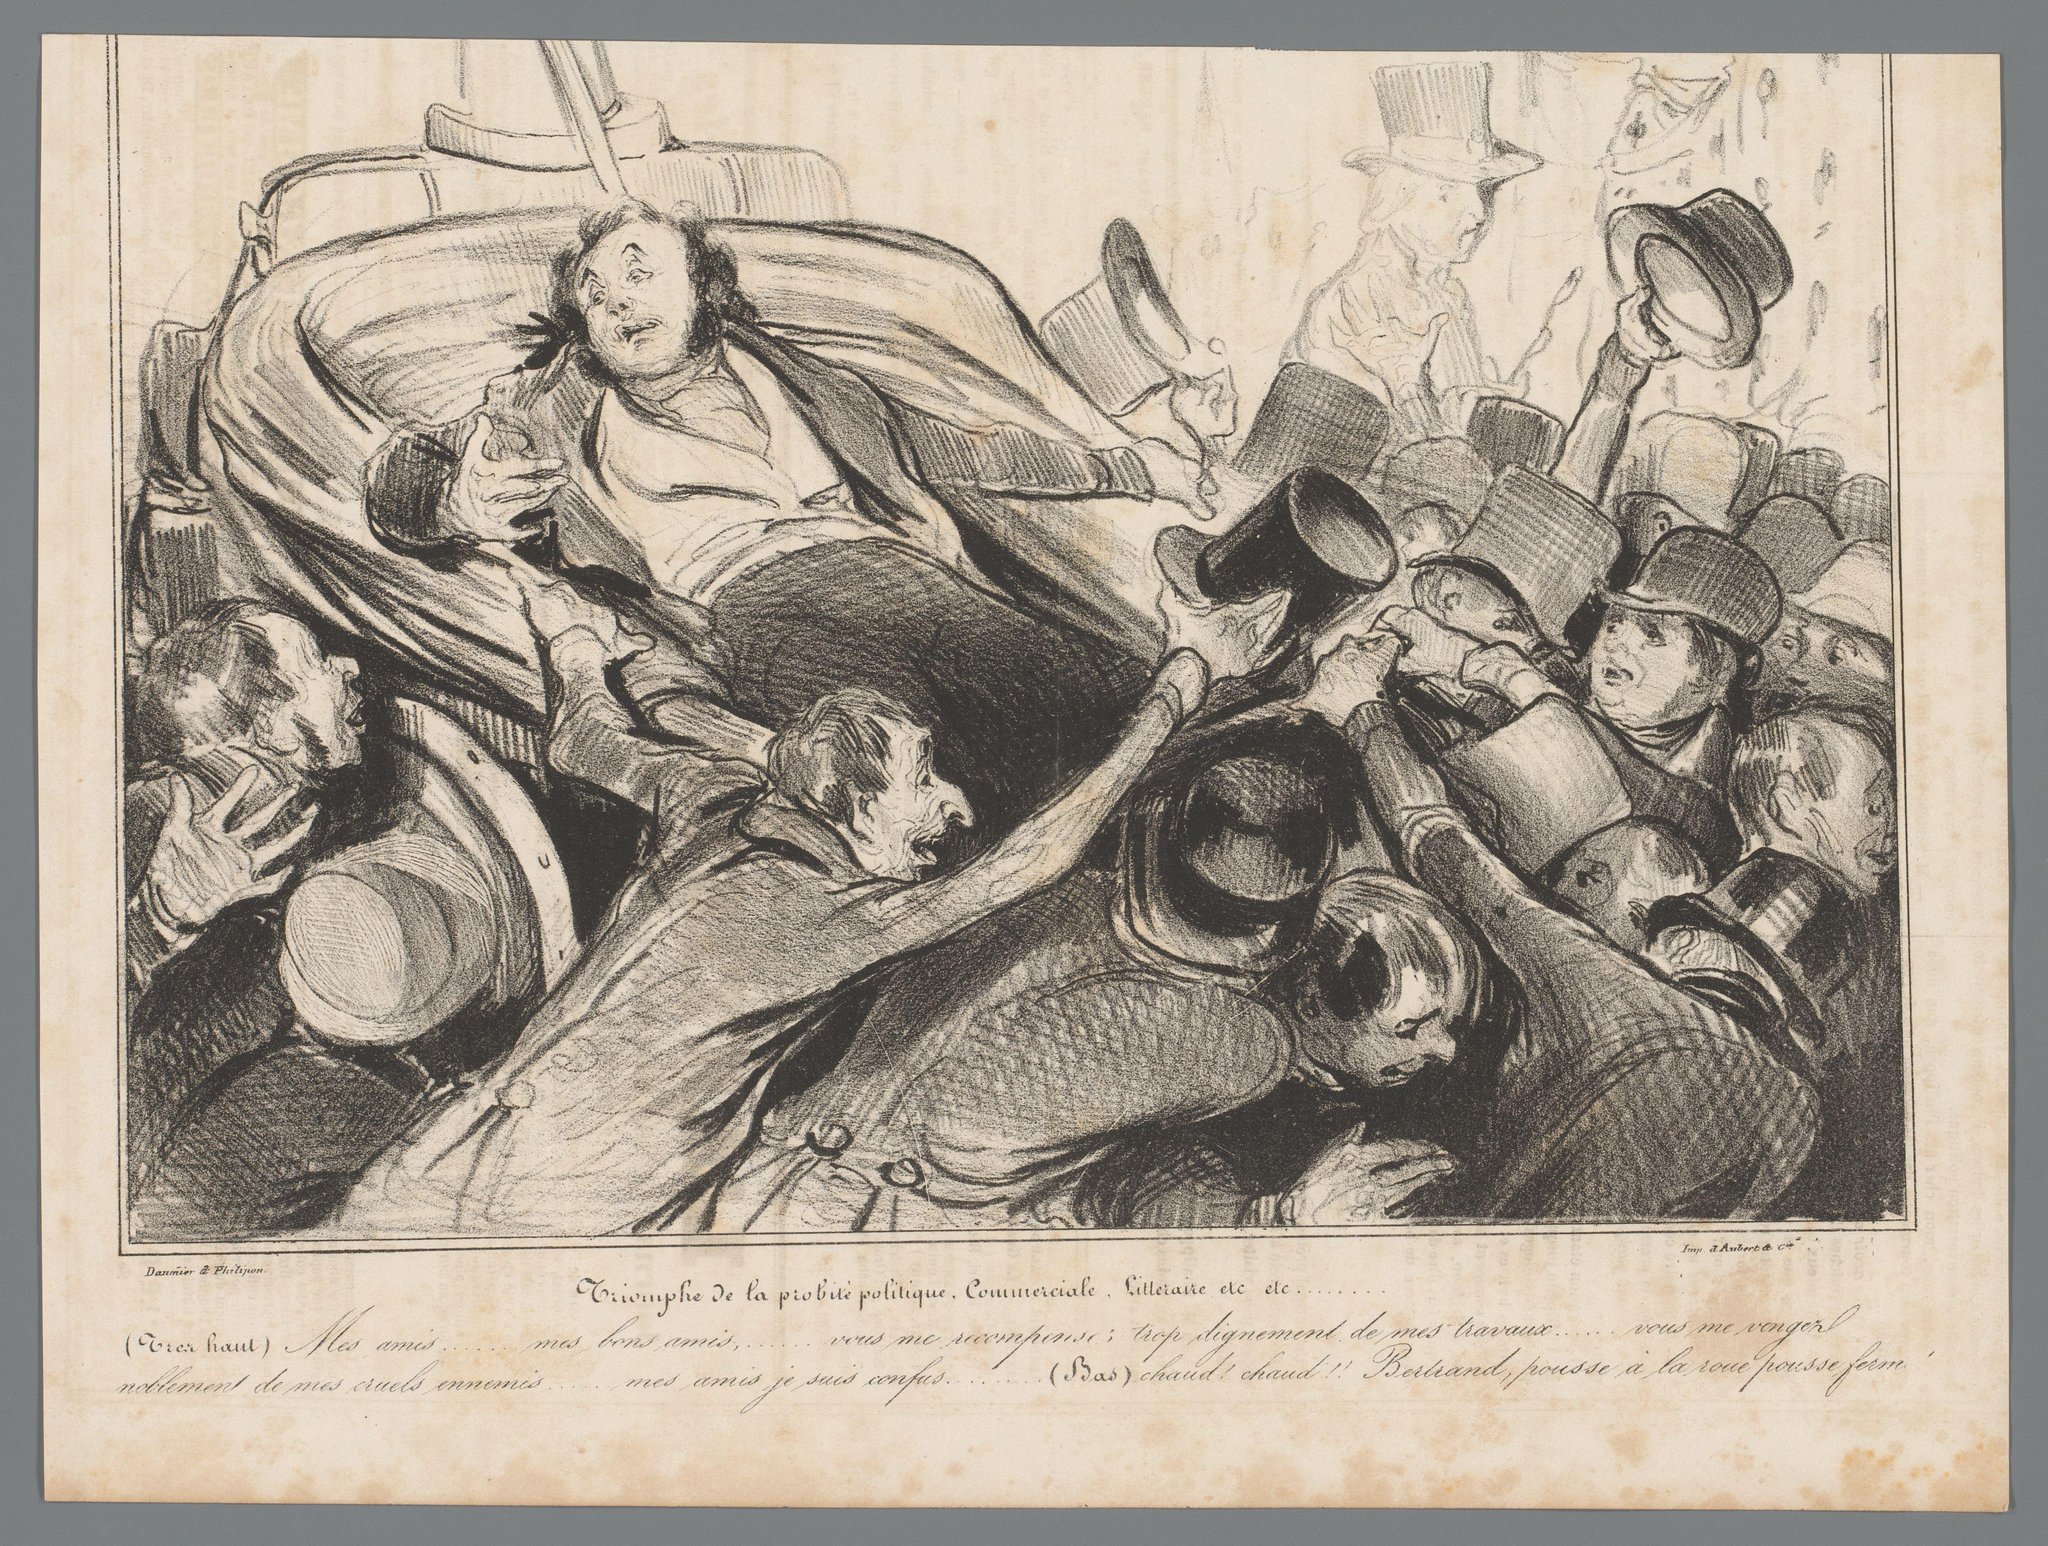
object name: cartoon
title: Karikaturen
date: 1838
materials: paper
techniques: letterpress printing, lithograph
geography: paris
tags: animal traction, animal-drawn vehicle (carriage etc.), crowd, mob, caricatures (human types)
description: Prent uit: Le Charivari, 18 oktober 1838.